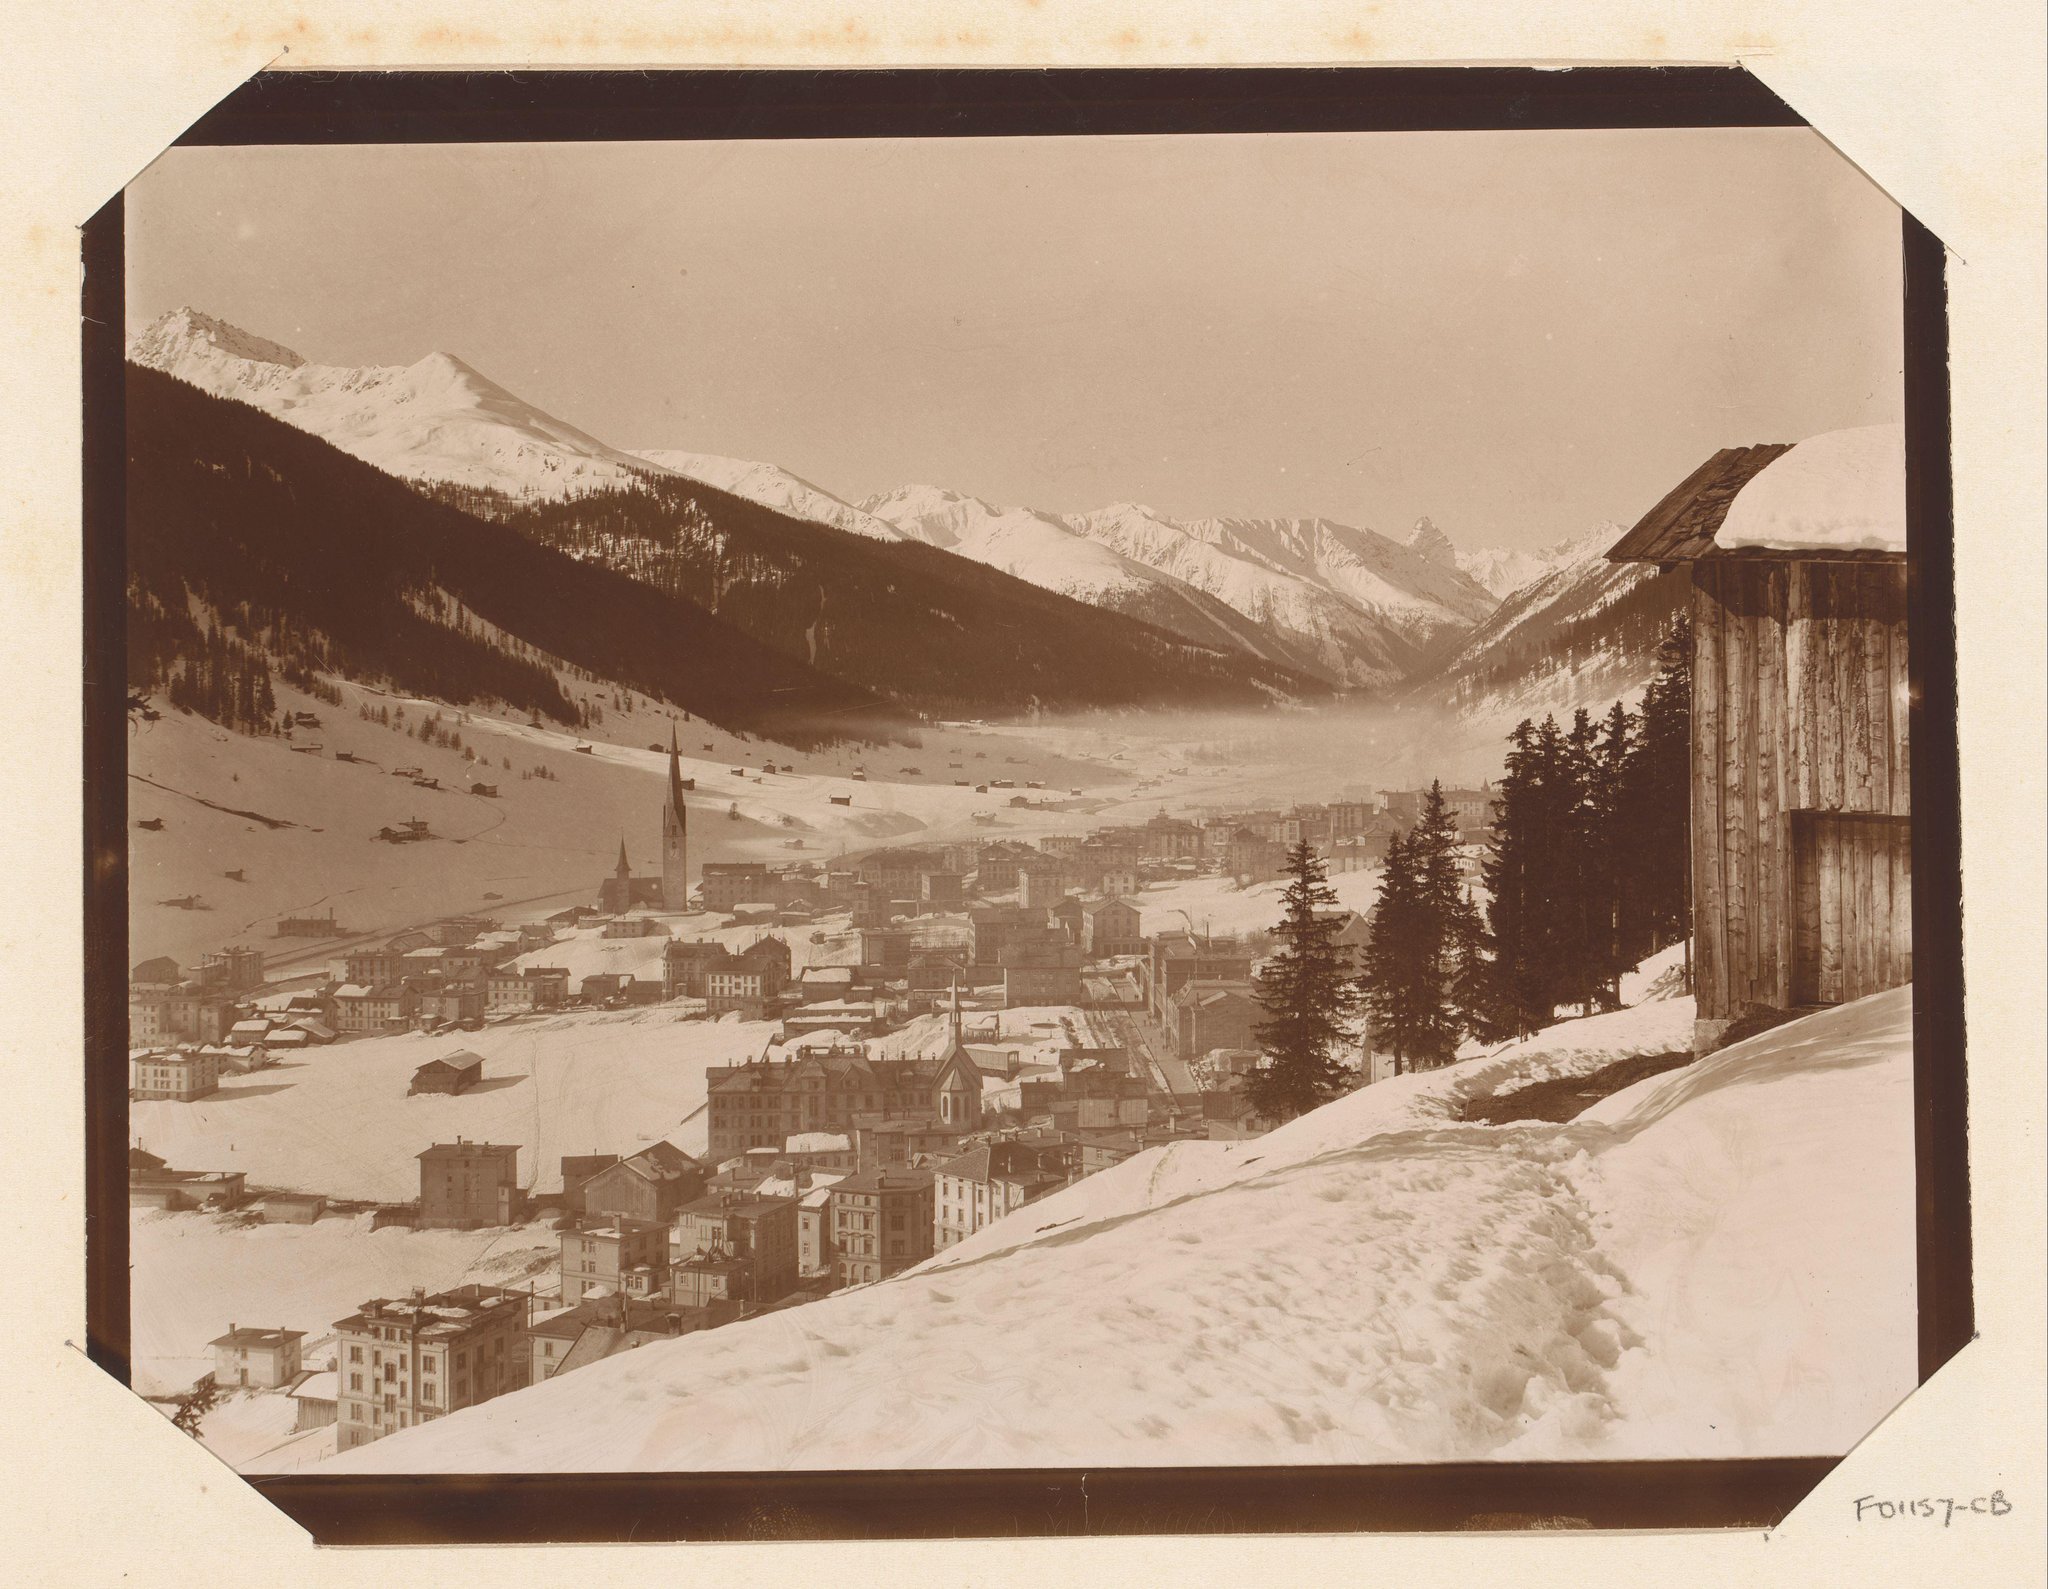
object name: photograph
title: Gezicht op een besneeuwd Davos met op de achtergrond bergen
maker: Anonymous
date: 1885-1892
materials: photographic support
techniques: albumen print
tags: city-view in general; 'veduta', snow, mountains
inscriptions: annotation: ‘Davos - Panorama’